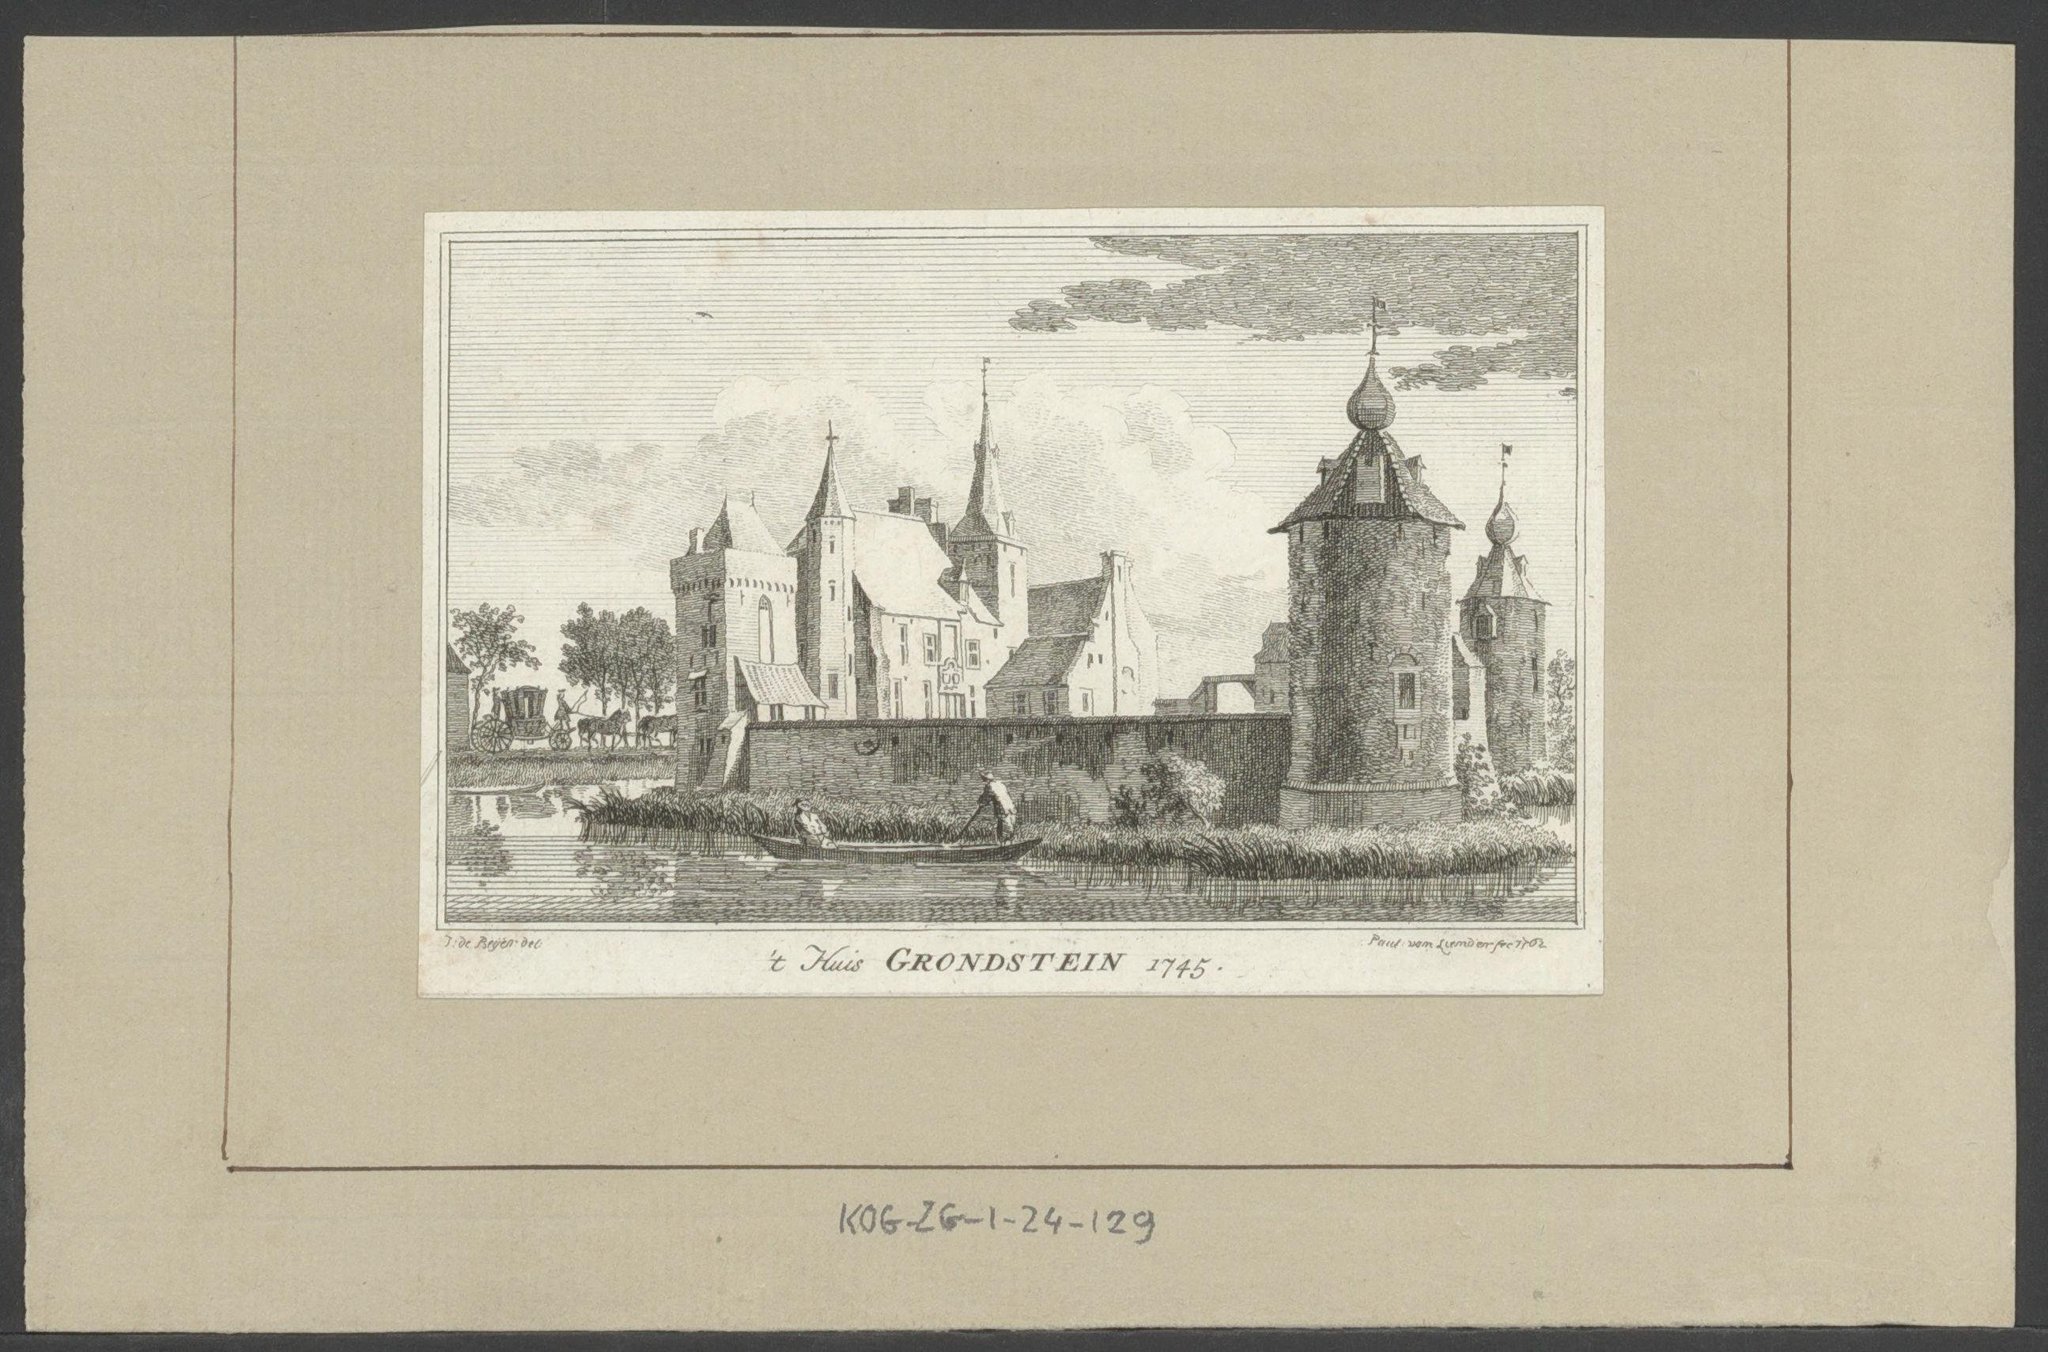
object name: print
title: 't Huis Grondstein 1745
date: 1762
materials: paper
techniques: etching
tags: castle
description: Gezicht op Kasteel Grondstein nabij het Duitse dorp Elten. De prent maakt deel uit van een 100-delige serie met gezichten op dorpen en steden te Kleef. Onderwerpsrubrieken binnen de Atlas Zeden en Gewoonten: Zeden en Gewoonten in Engeren Zin, De Woning. Kastelen en buitenplaatsen. Over de Grenzen.